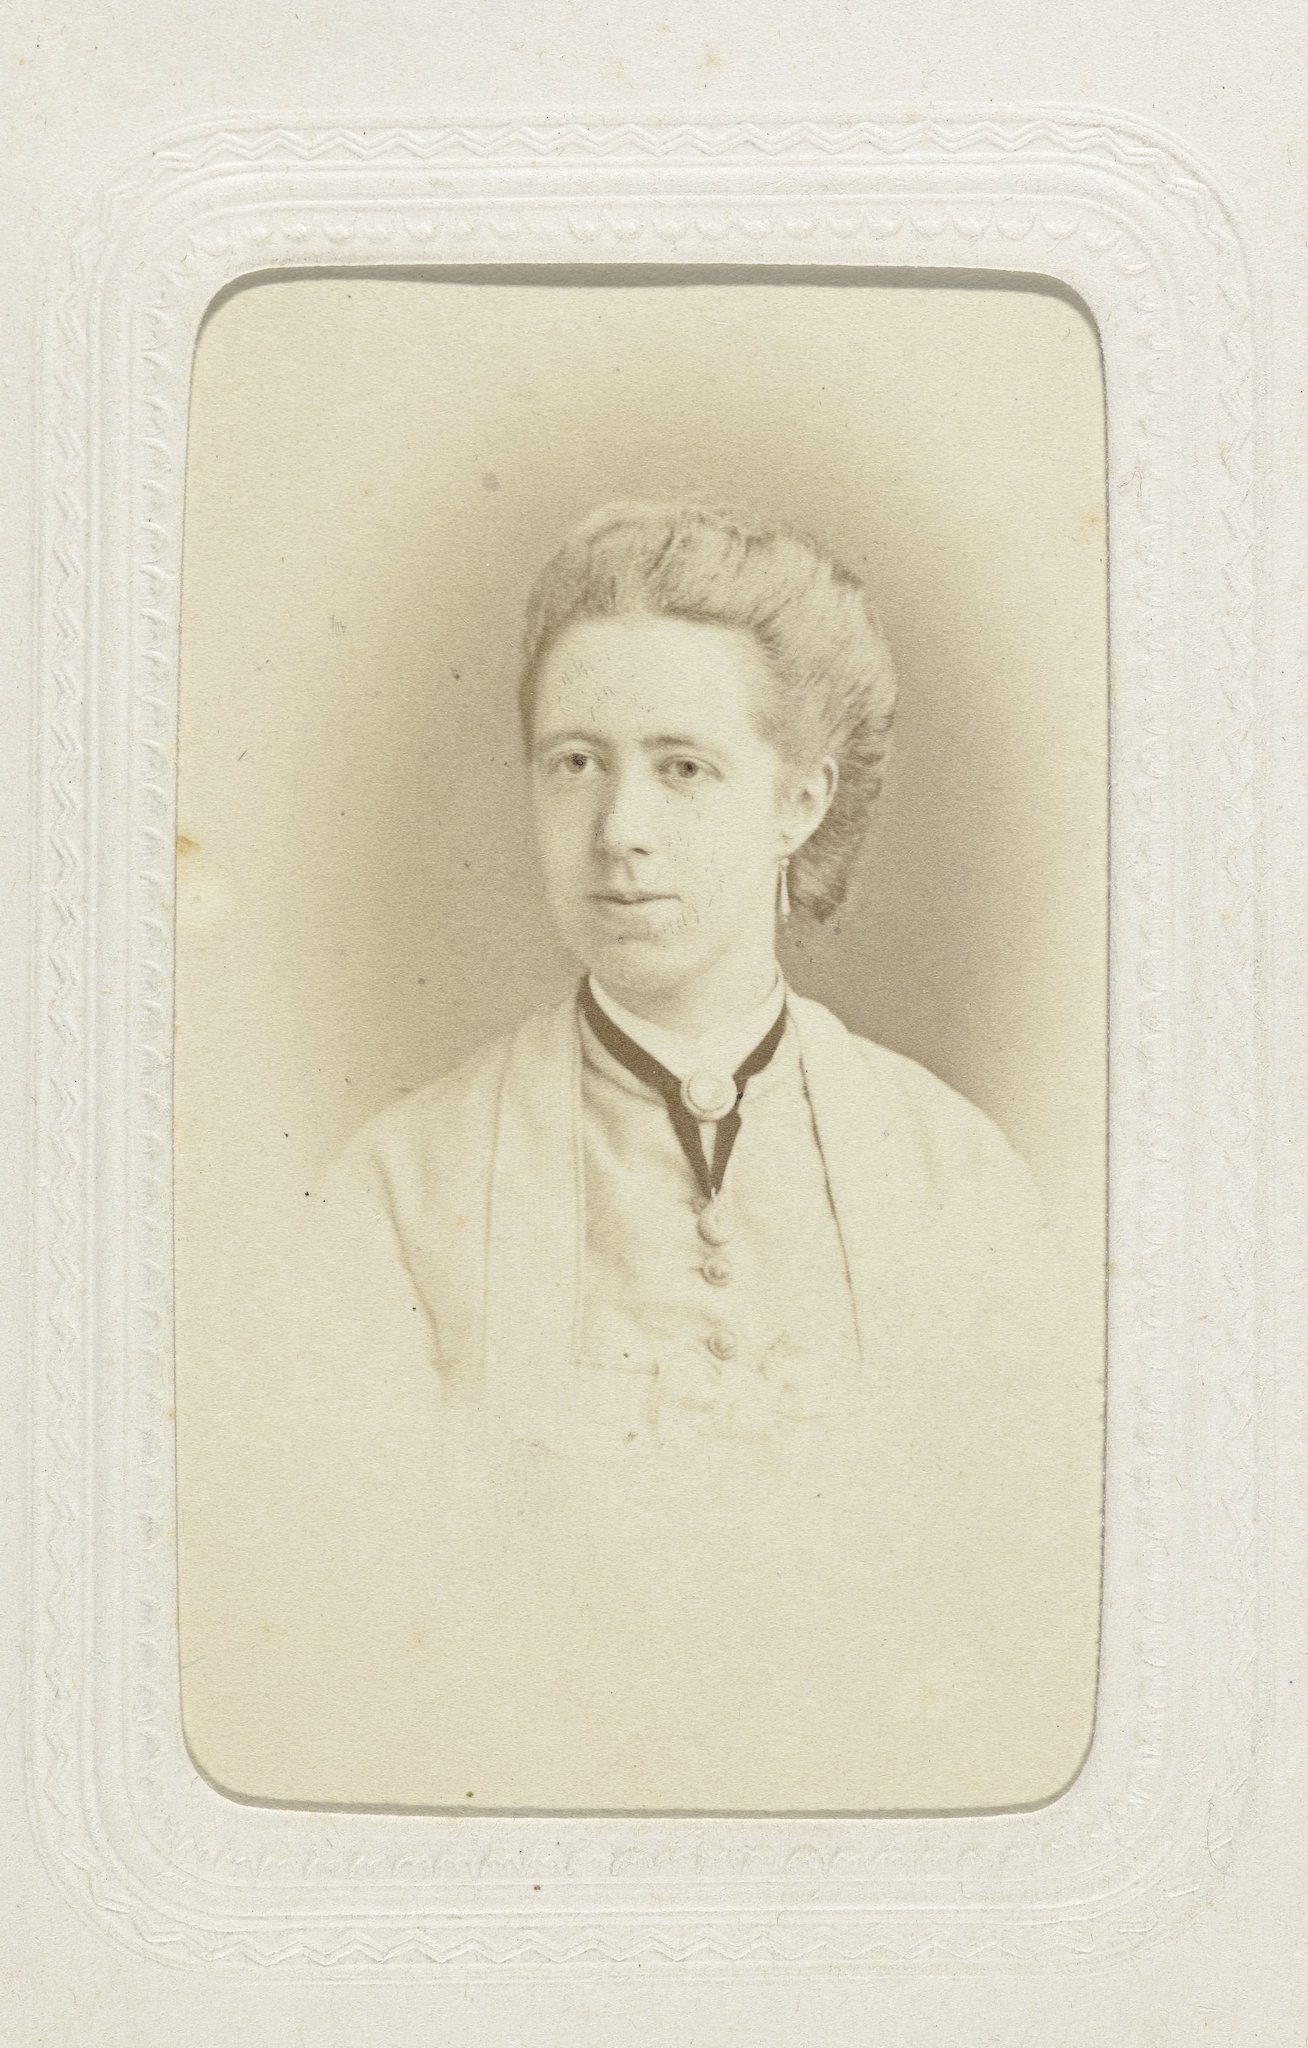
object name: carte de visite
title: Studioportret van een vrouw met opgestoken haar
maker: m.l winter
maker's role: fotograaf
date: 1863-1870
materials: cardboard, paper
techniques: albumen print